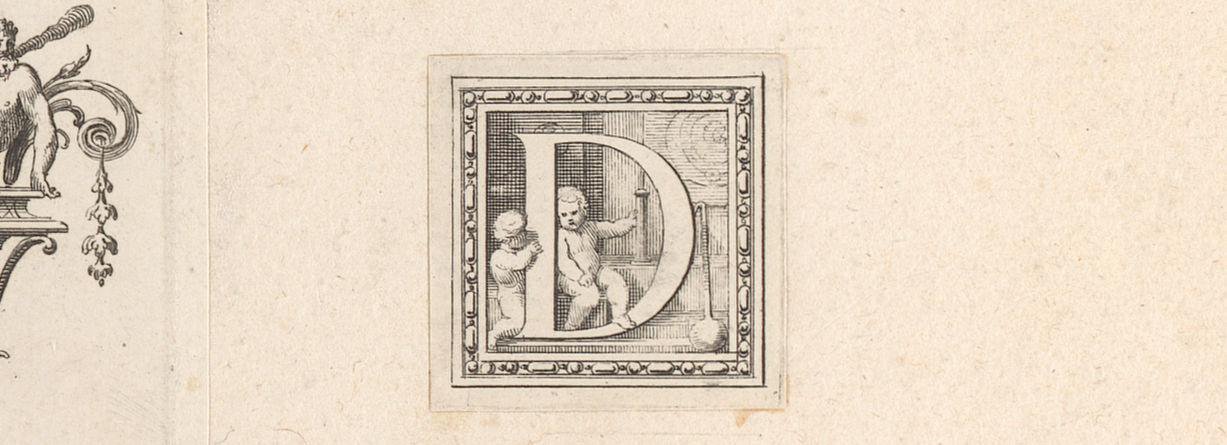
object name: print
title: Initiaal 'D' met twee putti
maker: sébastien leclerc (i)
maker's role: print maker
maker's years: 1637-1714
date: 1647-1714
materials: paper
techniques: etching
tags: initial, cupids: 'amores', 'amoretti', 'putti'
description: Prent uit een editie van: Roger de La Rochefoucauld. Theses philosophicas (...).